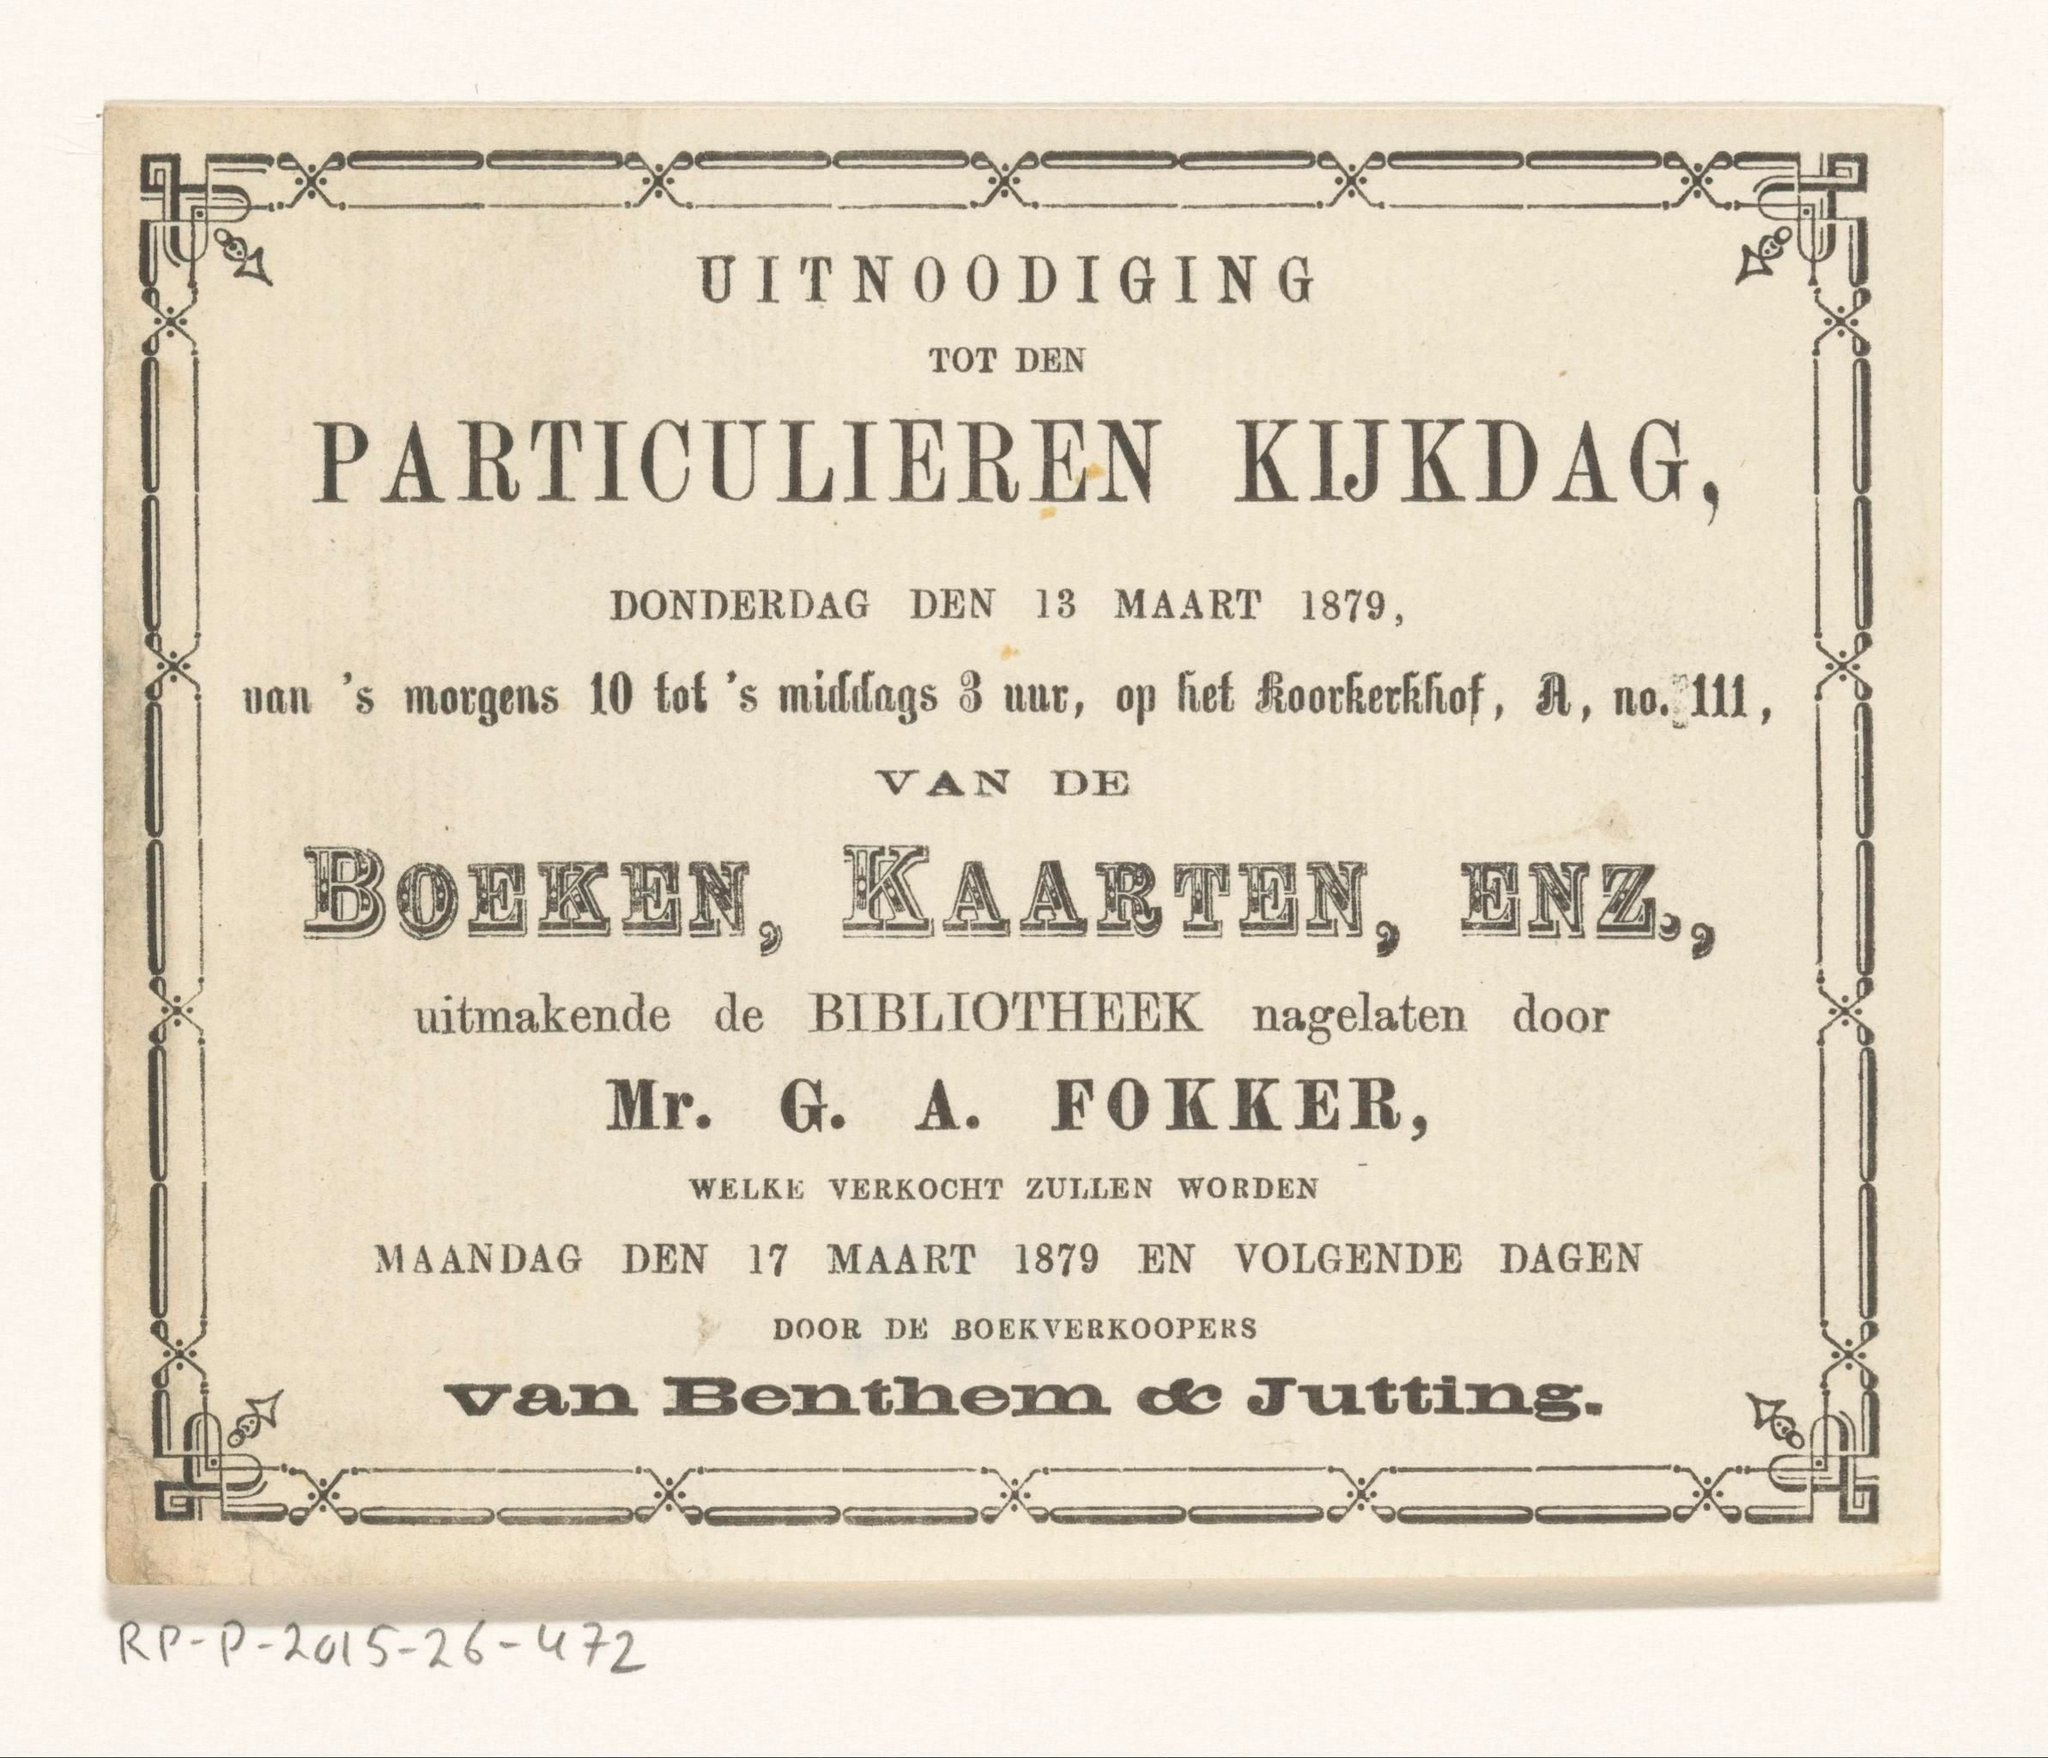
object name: print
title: Uitnodiging voor de kijkdag van een boekenveiling bij Van Benthem & Jutting te Middelburg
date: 1803-1879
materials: paper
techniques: letterpress printing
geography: middelburg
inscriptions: collector's mark: Lugt 2228, collector's mark: Lugt 4779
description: De veiling betreft de collectie van G.A. Fokker.